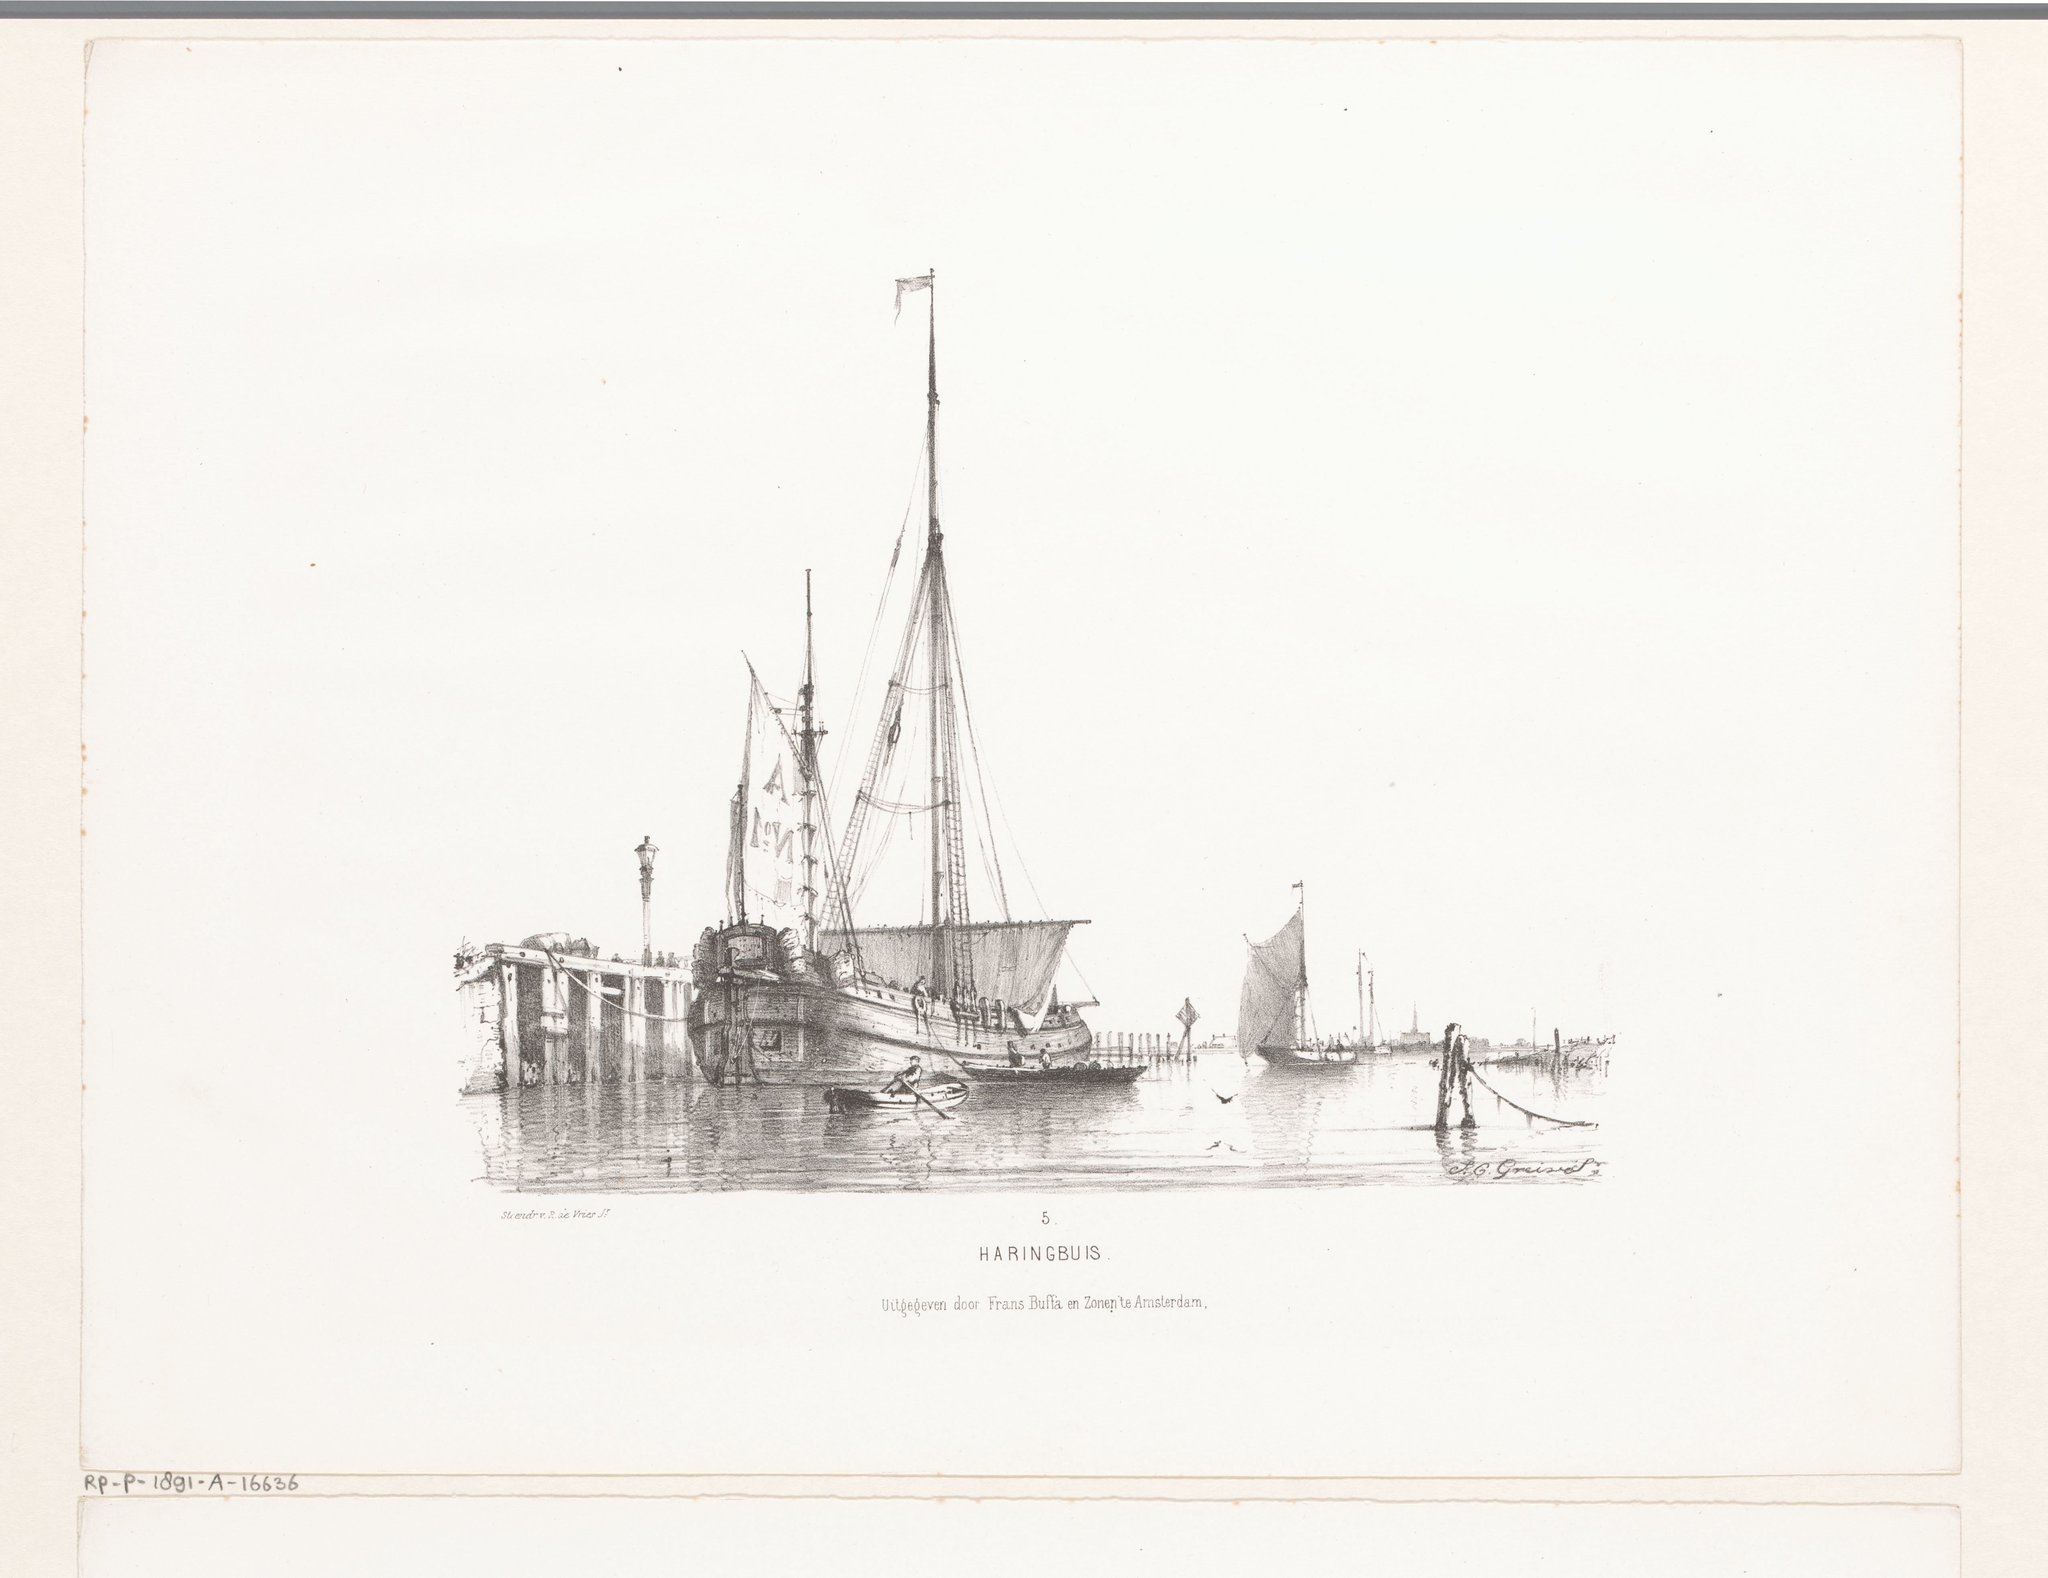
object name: print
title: Studiën van Hollandsche Schepen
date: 1860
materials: paper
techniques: lithograph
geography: netherlands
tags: sailing-ship, sailing-boat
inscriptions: collector's mark: Lugt 2228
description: Een figuur in een roeiboot vaart richting de Haringbuis.